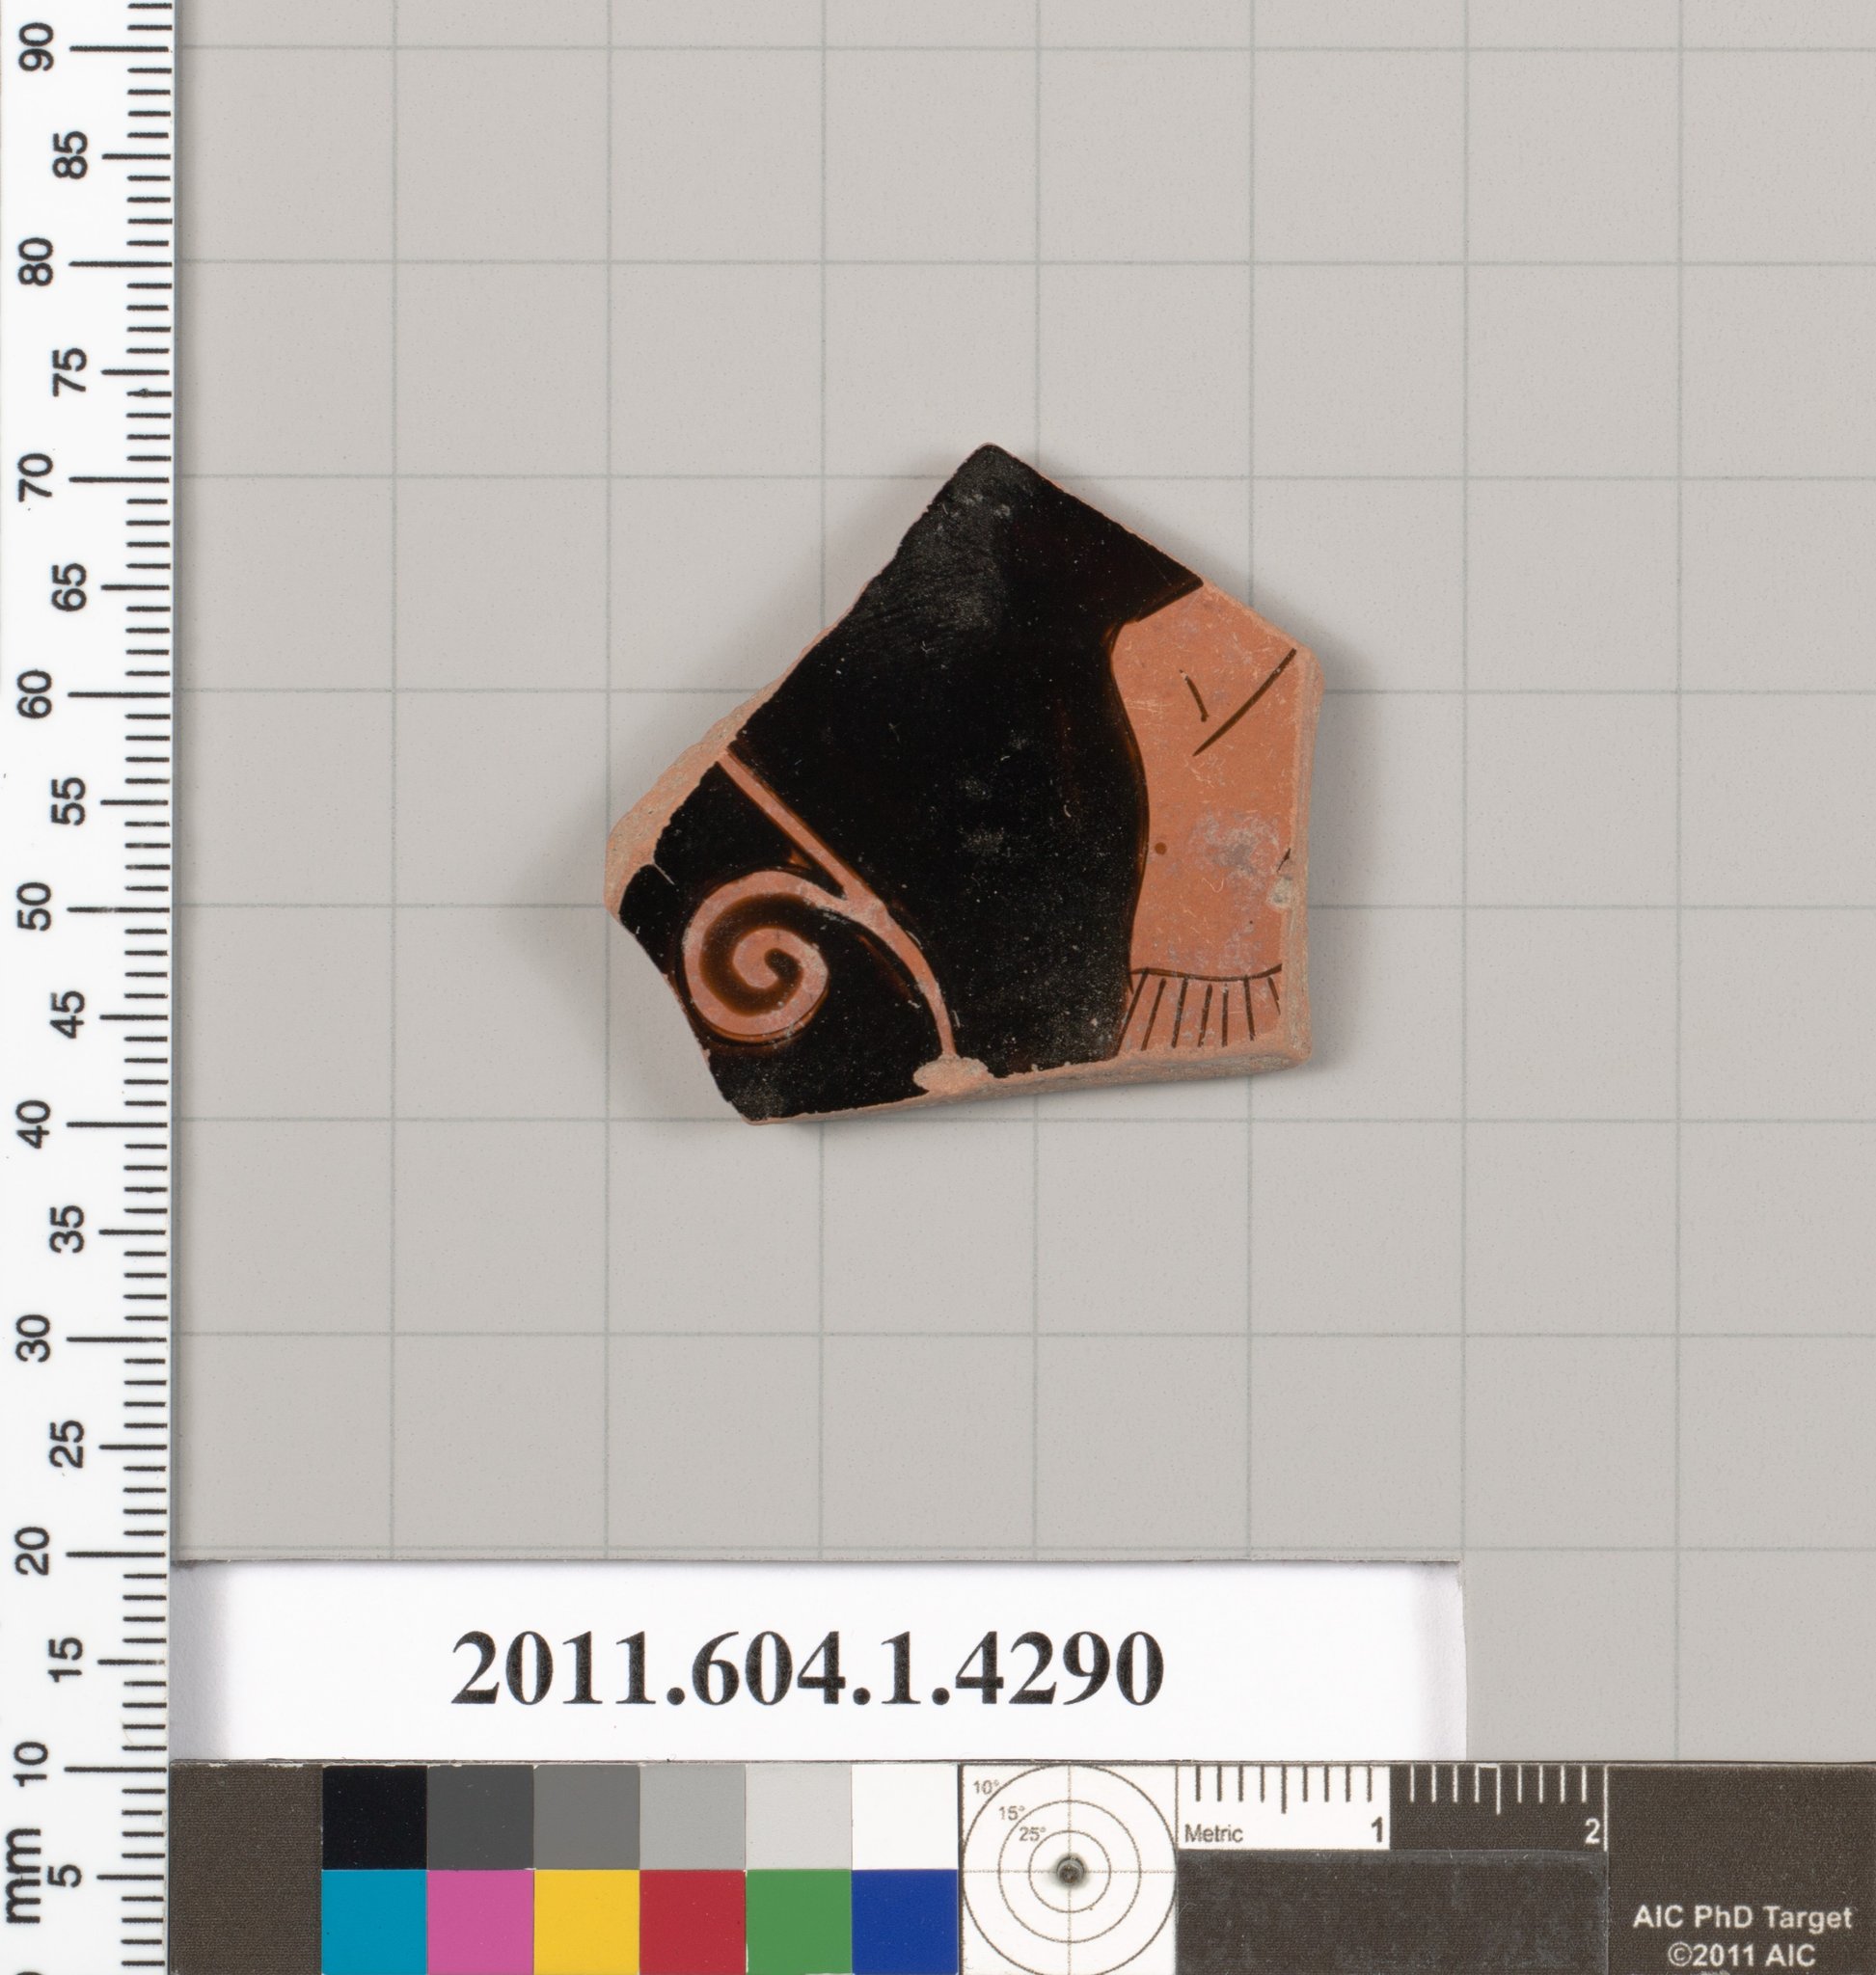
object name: kylix fragment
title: Terracotta fragment of a kylix (drinking cup)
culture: greek, attic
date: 475-451 BCE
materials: terracotta